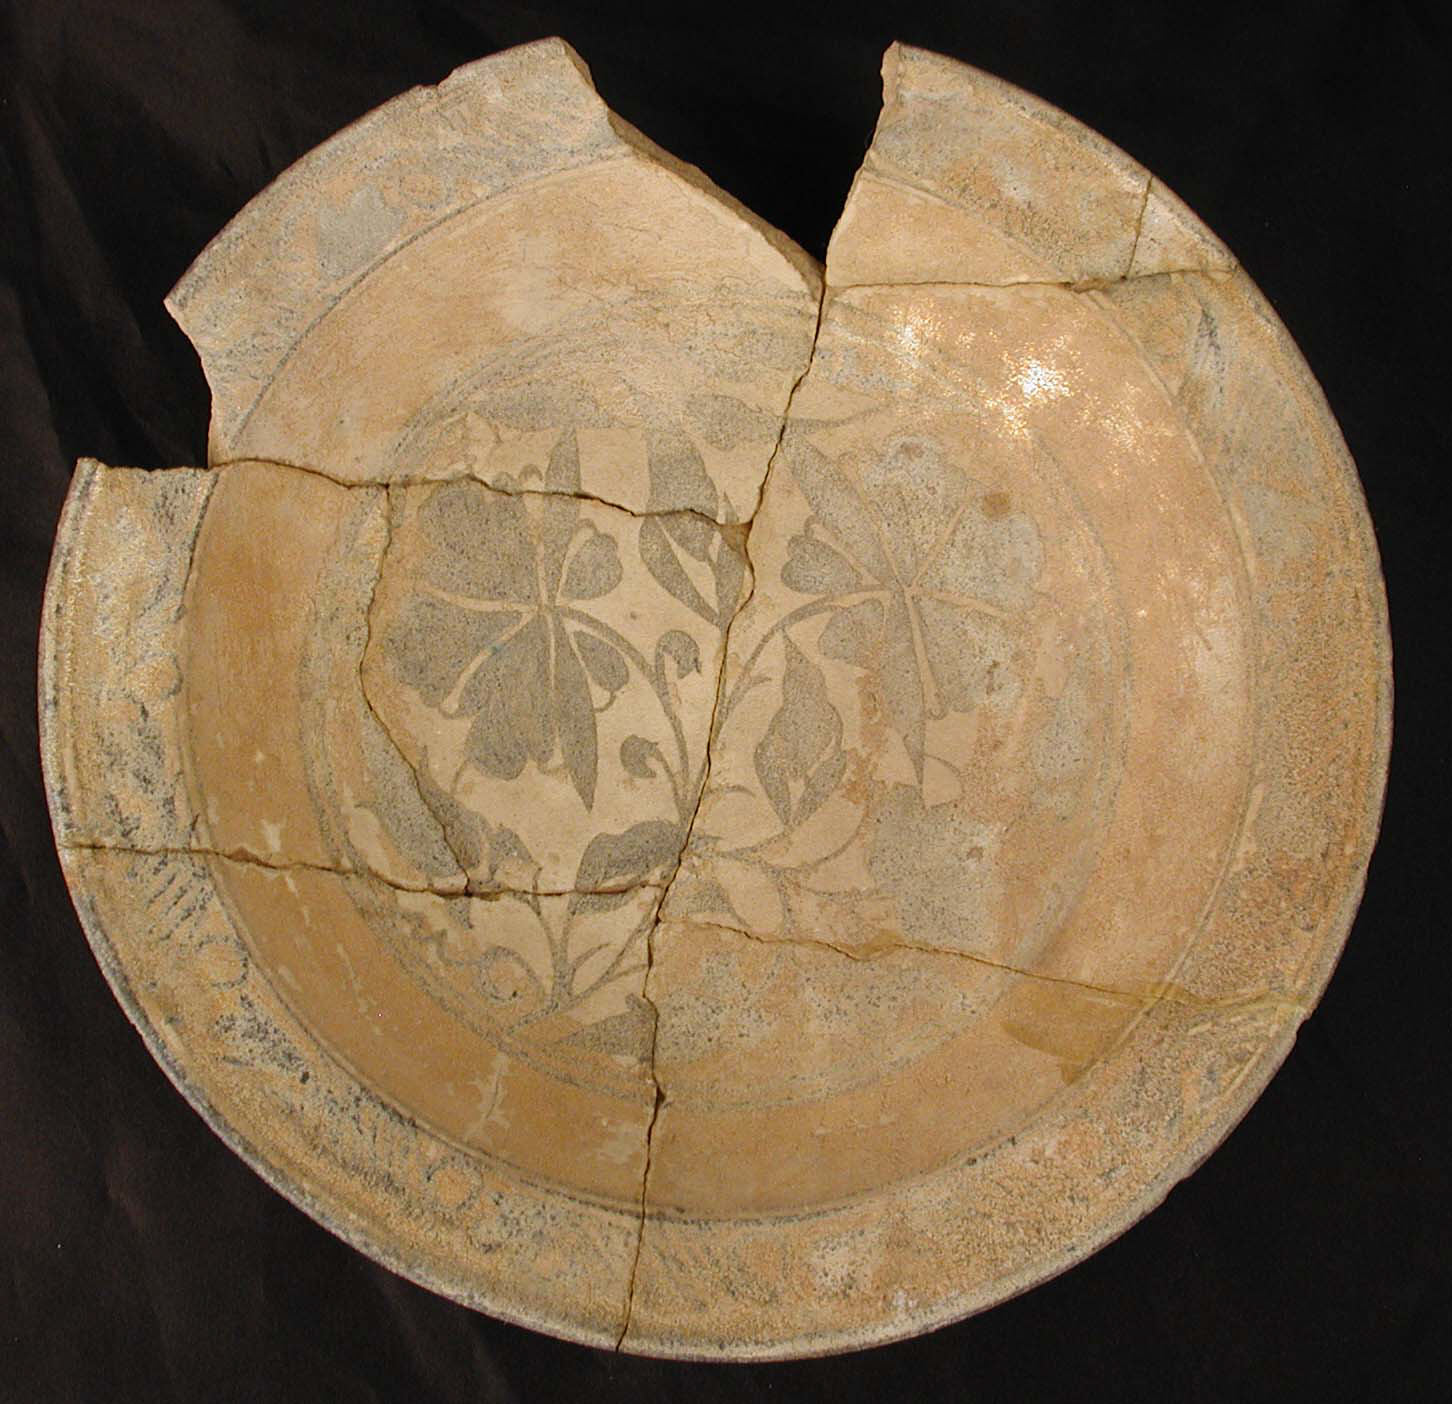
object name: bowl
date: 1401-1500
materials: earthenware, glaze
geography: iran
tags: flowers,leaves